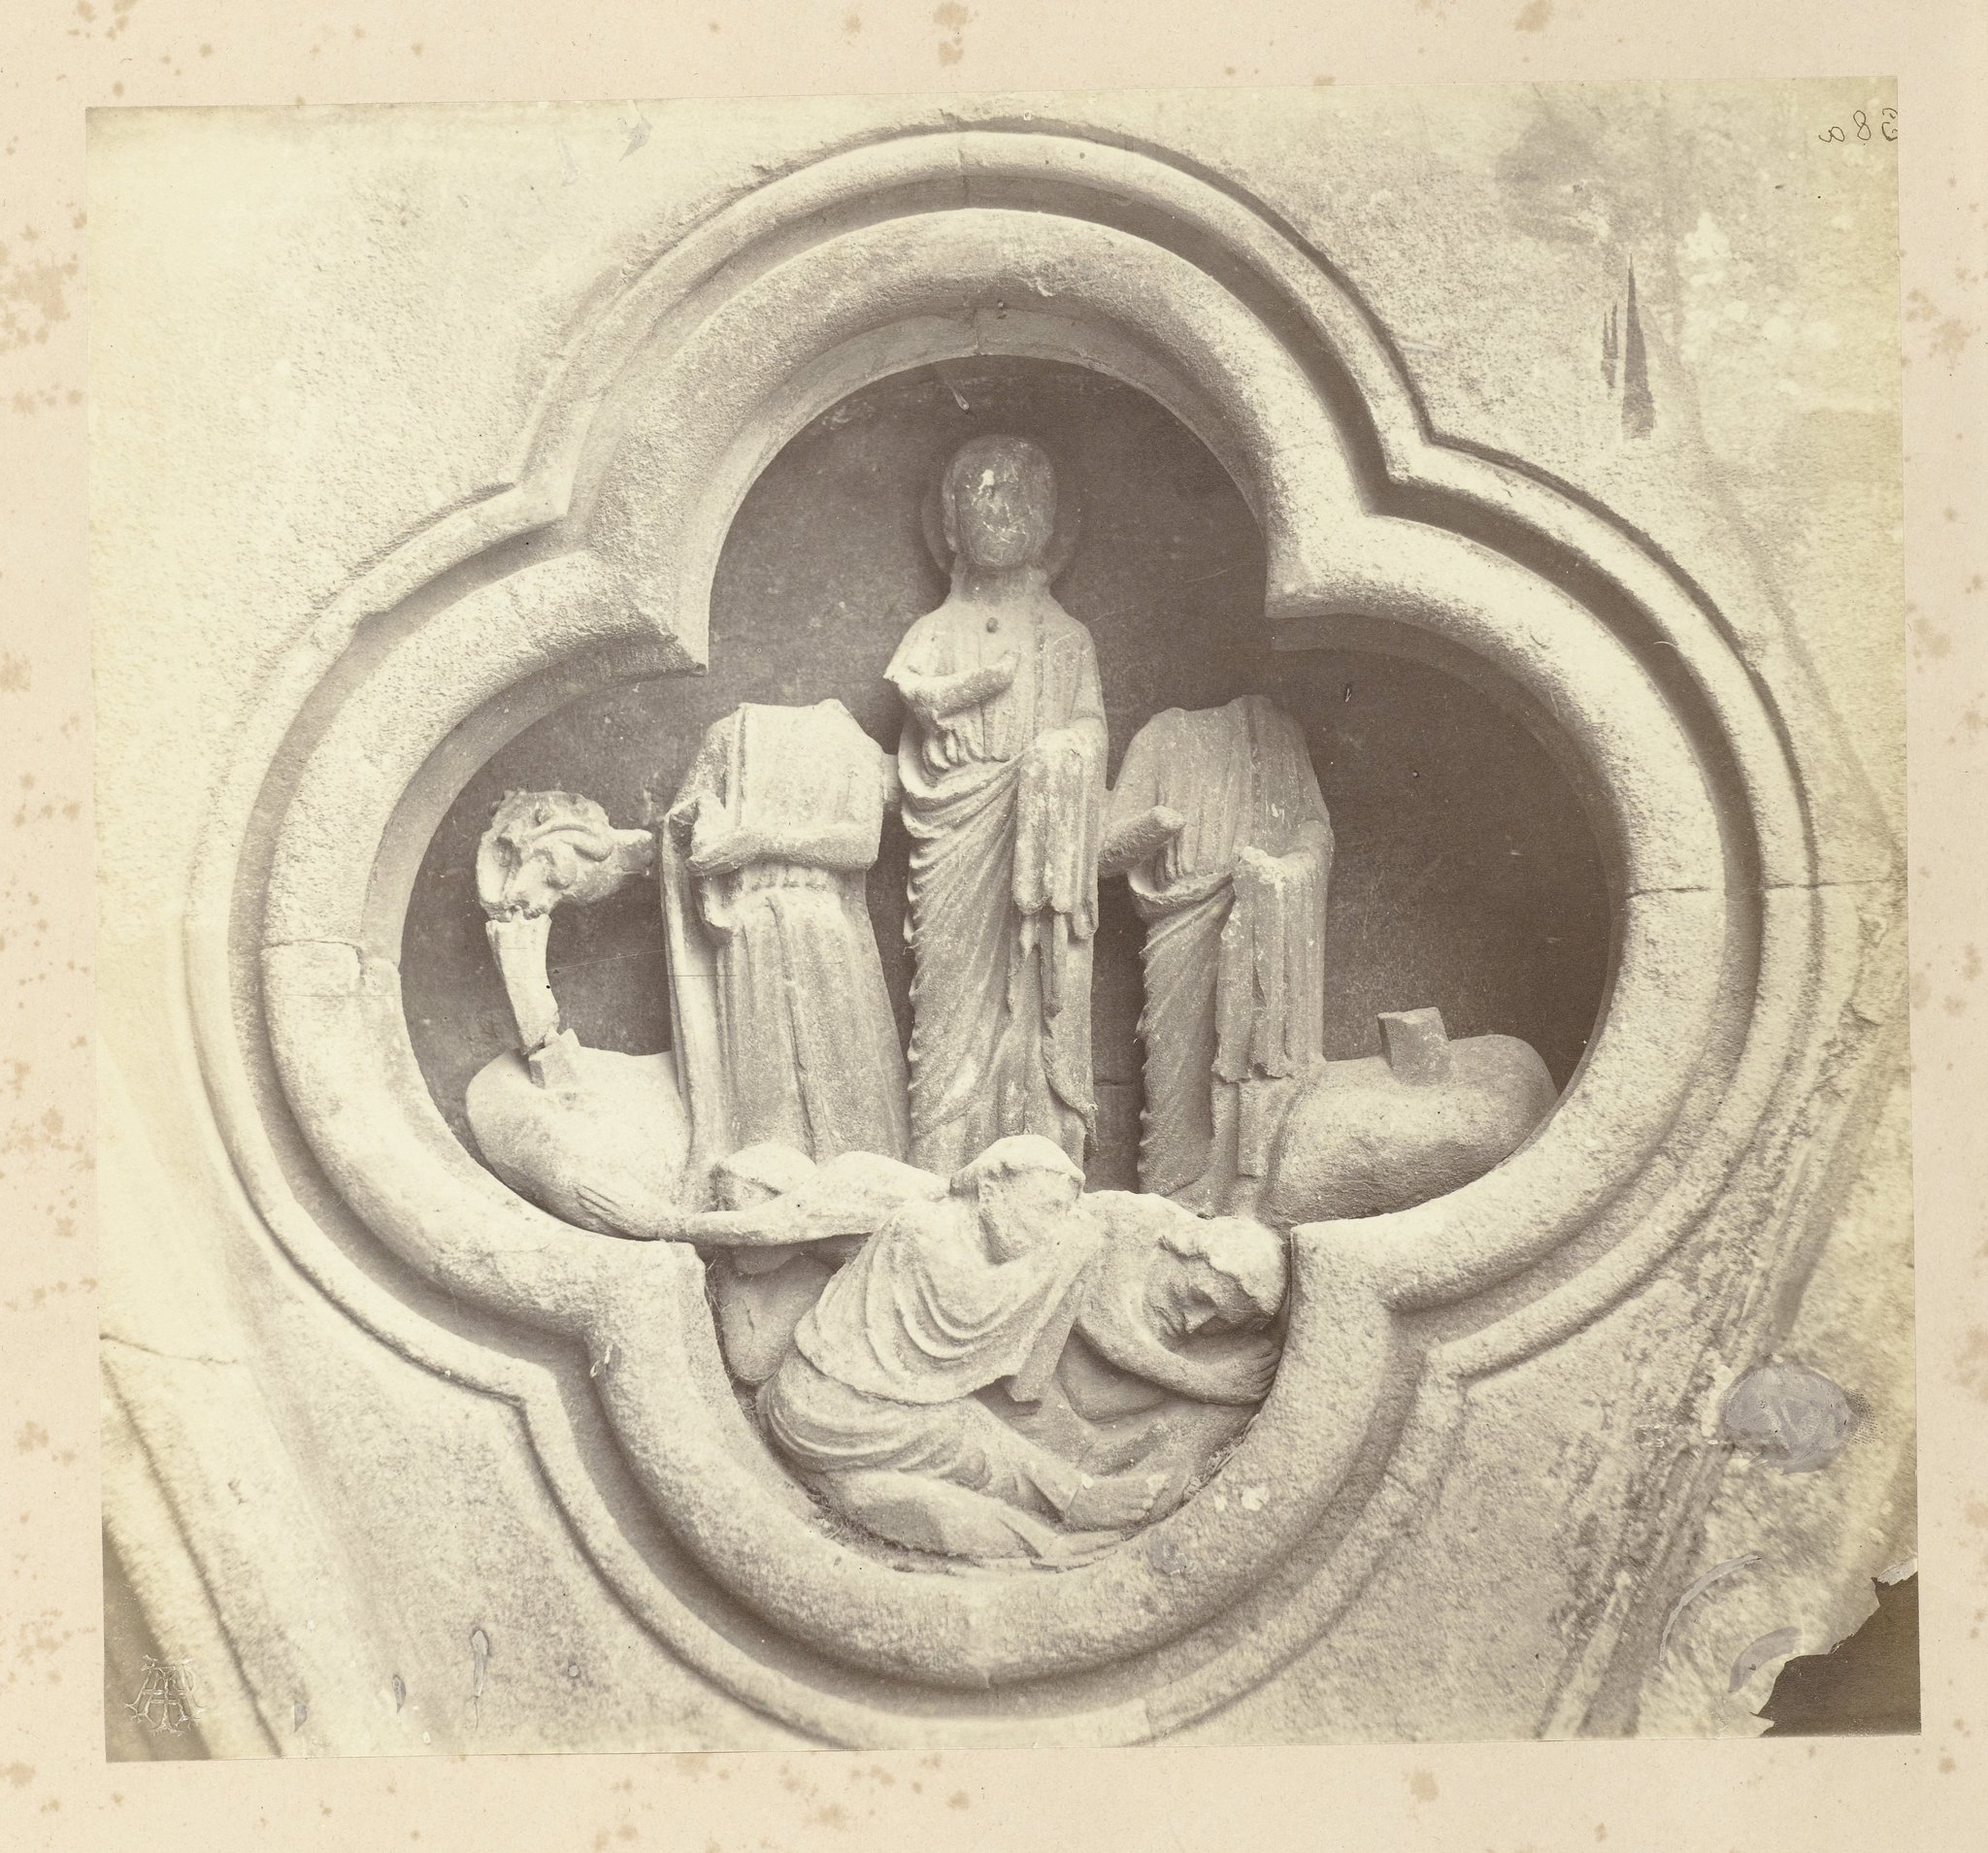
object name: photograph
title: Kathedraal te Wells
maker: Anonymous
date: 1858-1861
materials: cardboard, paper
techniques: albumen print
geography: london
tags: piece of sculpture, reproduction of a piece of sculpture, parts of church exterior and annexes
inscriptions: monogram: ‘APA’, address: ‘168 NEW BOND ST.’, number: ‘20 N.’